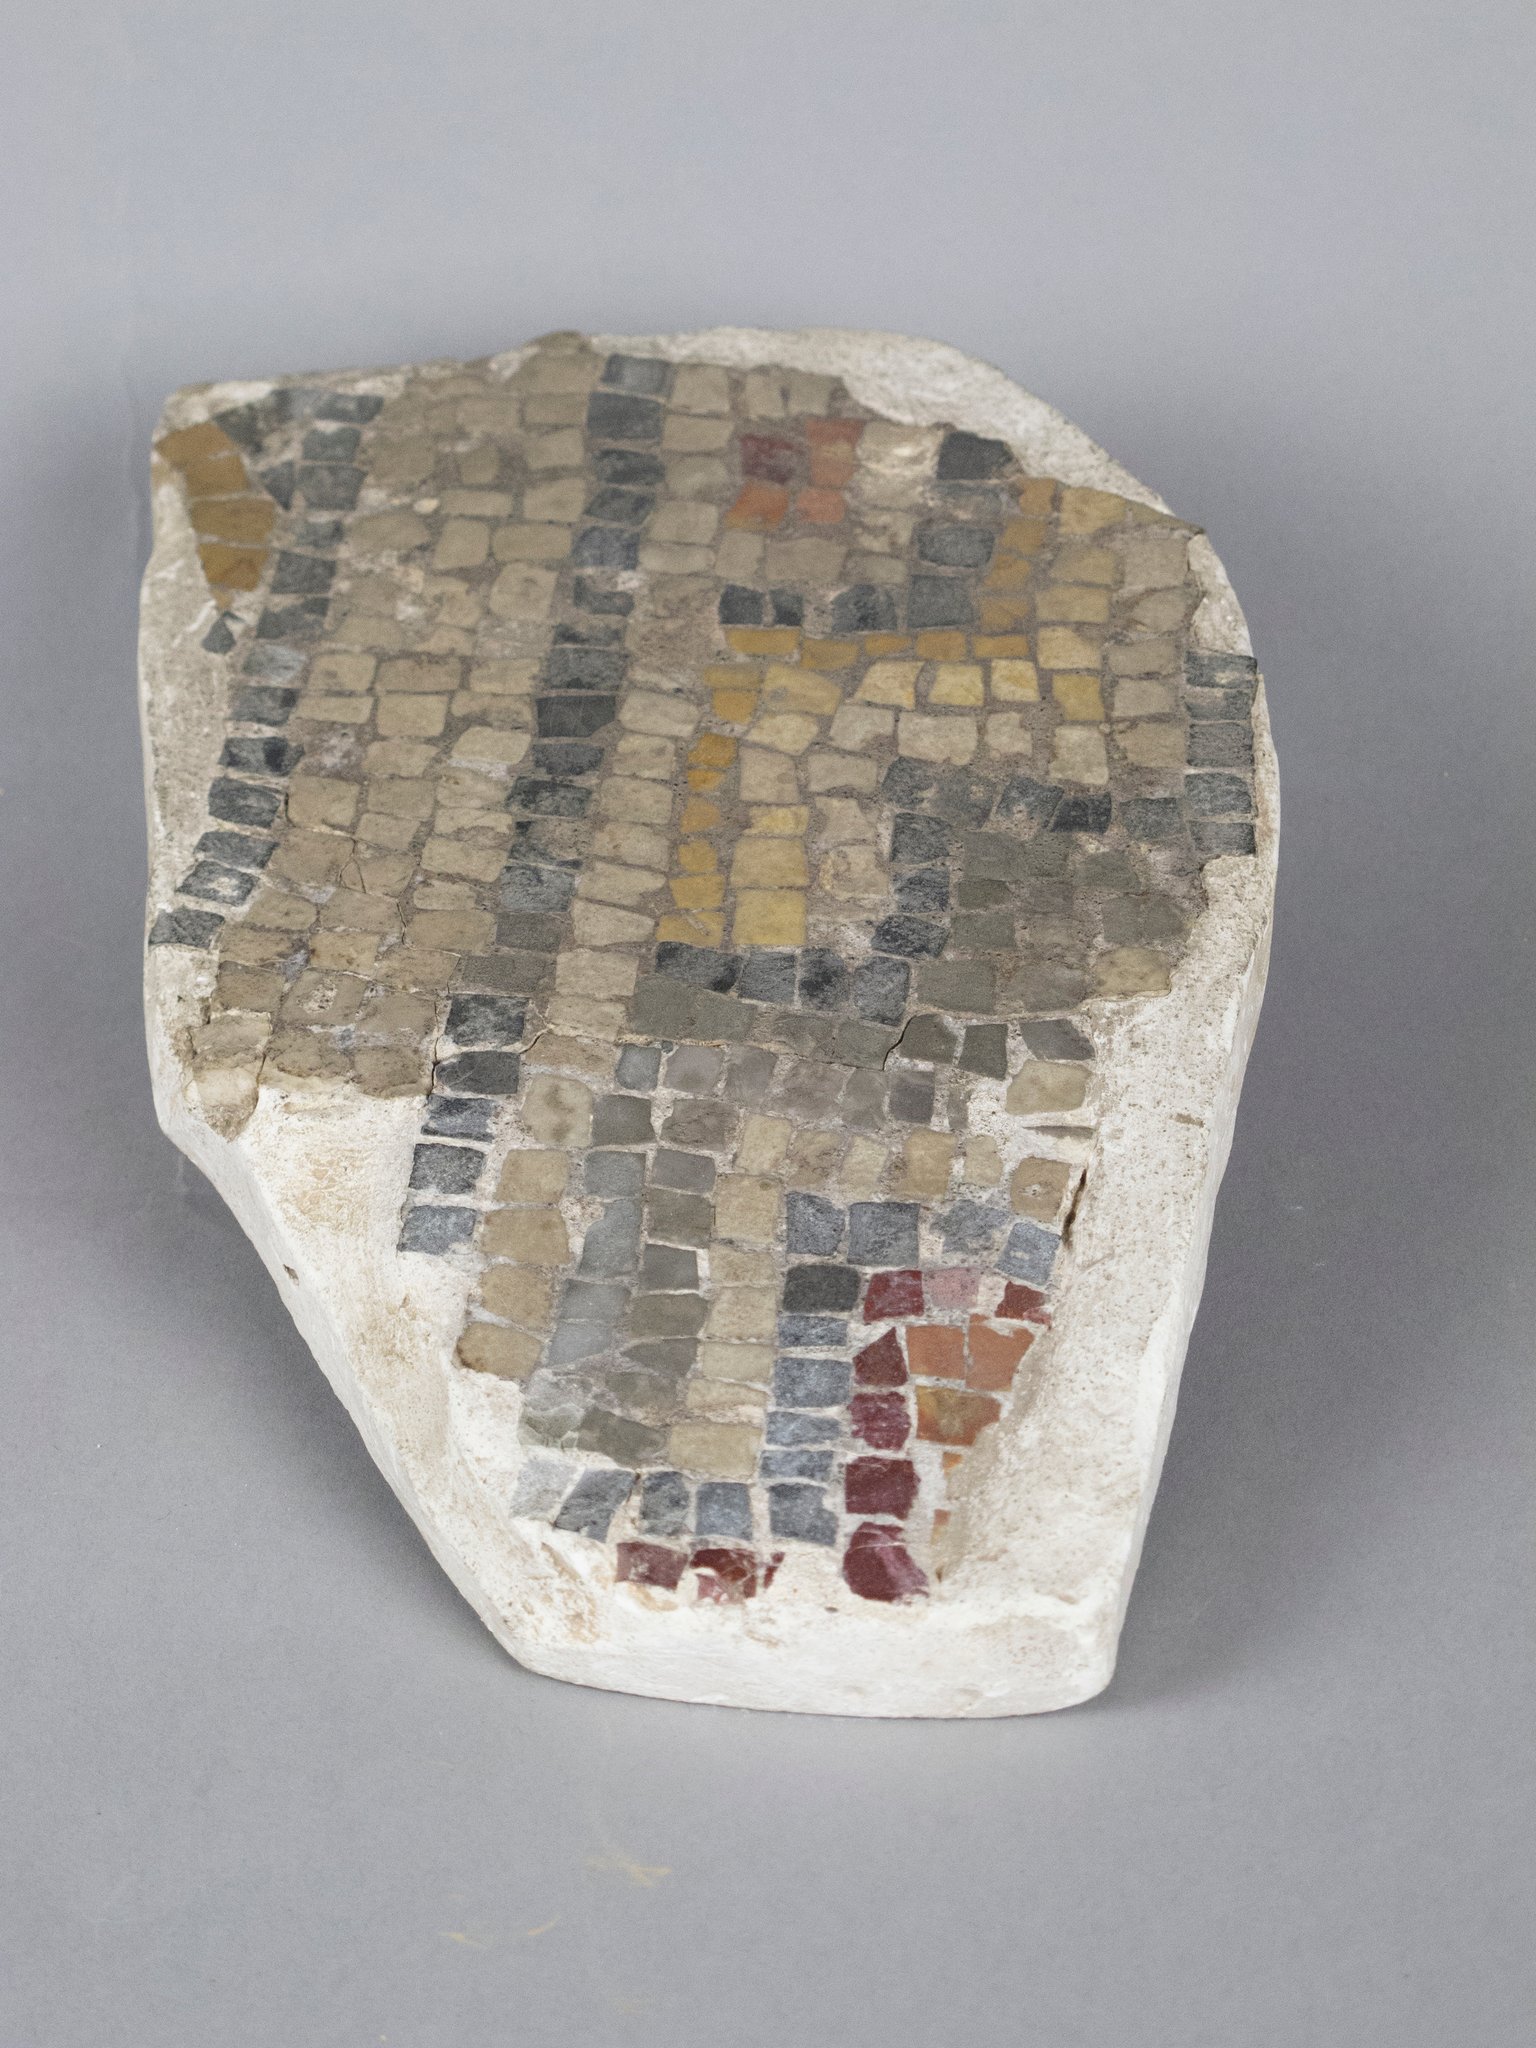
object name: mosaic pavement fragment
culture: roman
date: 670 BCE-330 CE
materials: mortar